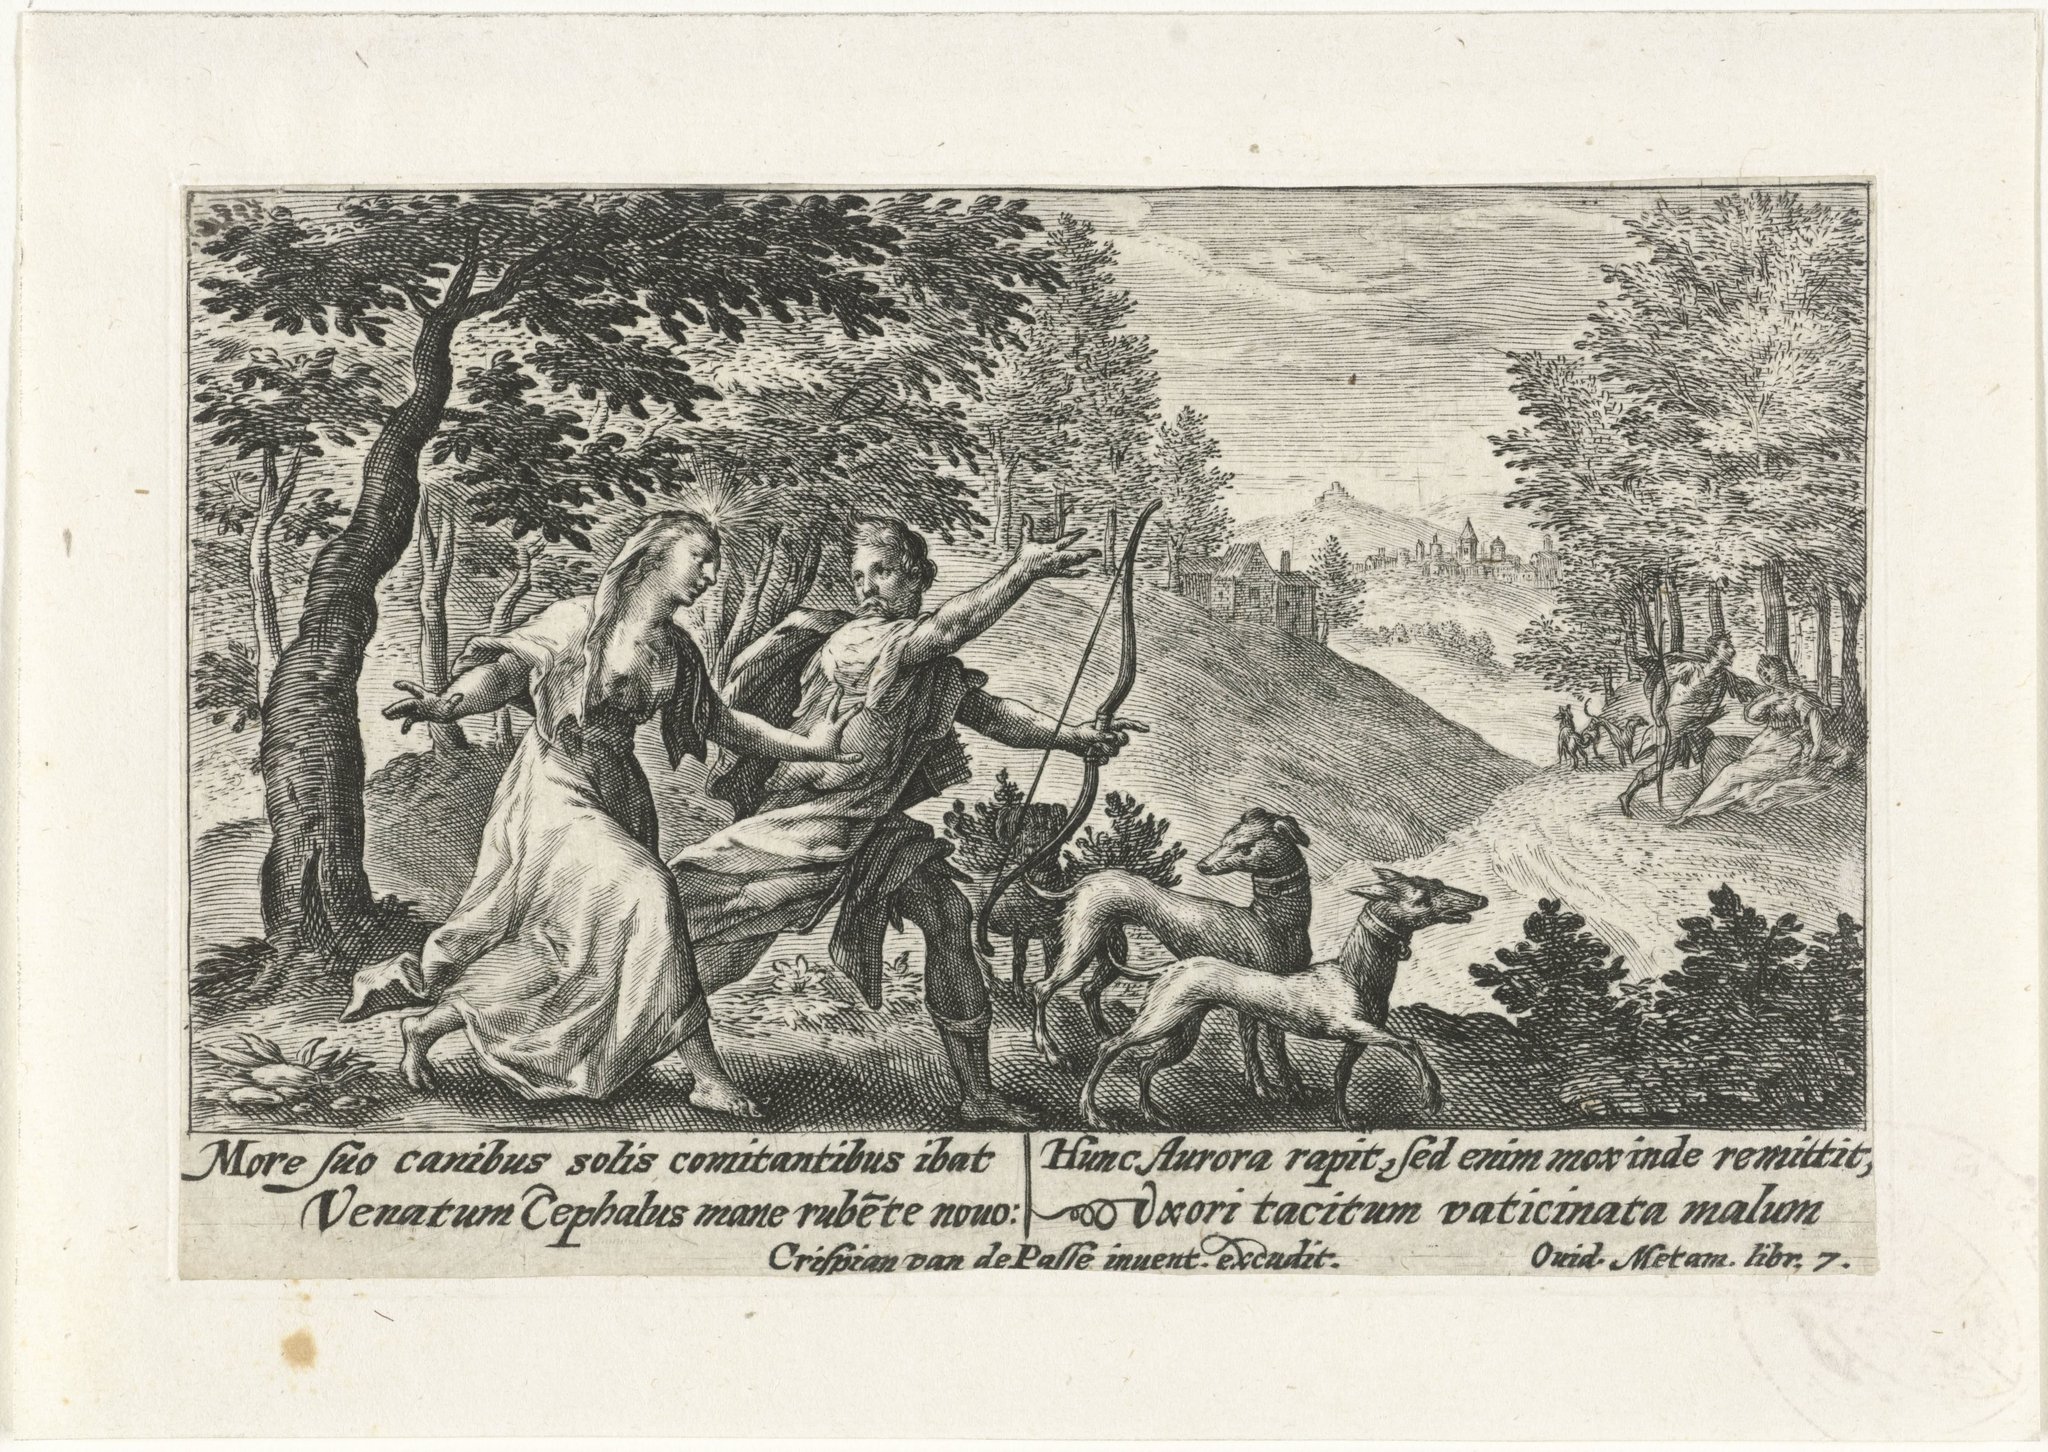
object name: print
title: Metamorfosen van Ovidius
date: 1602-1607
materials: paper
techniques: engraving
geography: cologne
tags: cephalus and aurora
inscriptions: collector's mark: Lugt 240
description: Aurora achtervolgt Cephalus, op wie zij verliefd is, maar hij wijst haar af. In de marge een vierregelig onderschrift, in twee kolommen, in het Latijn.